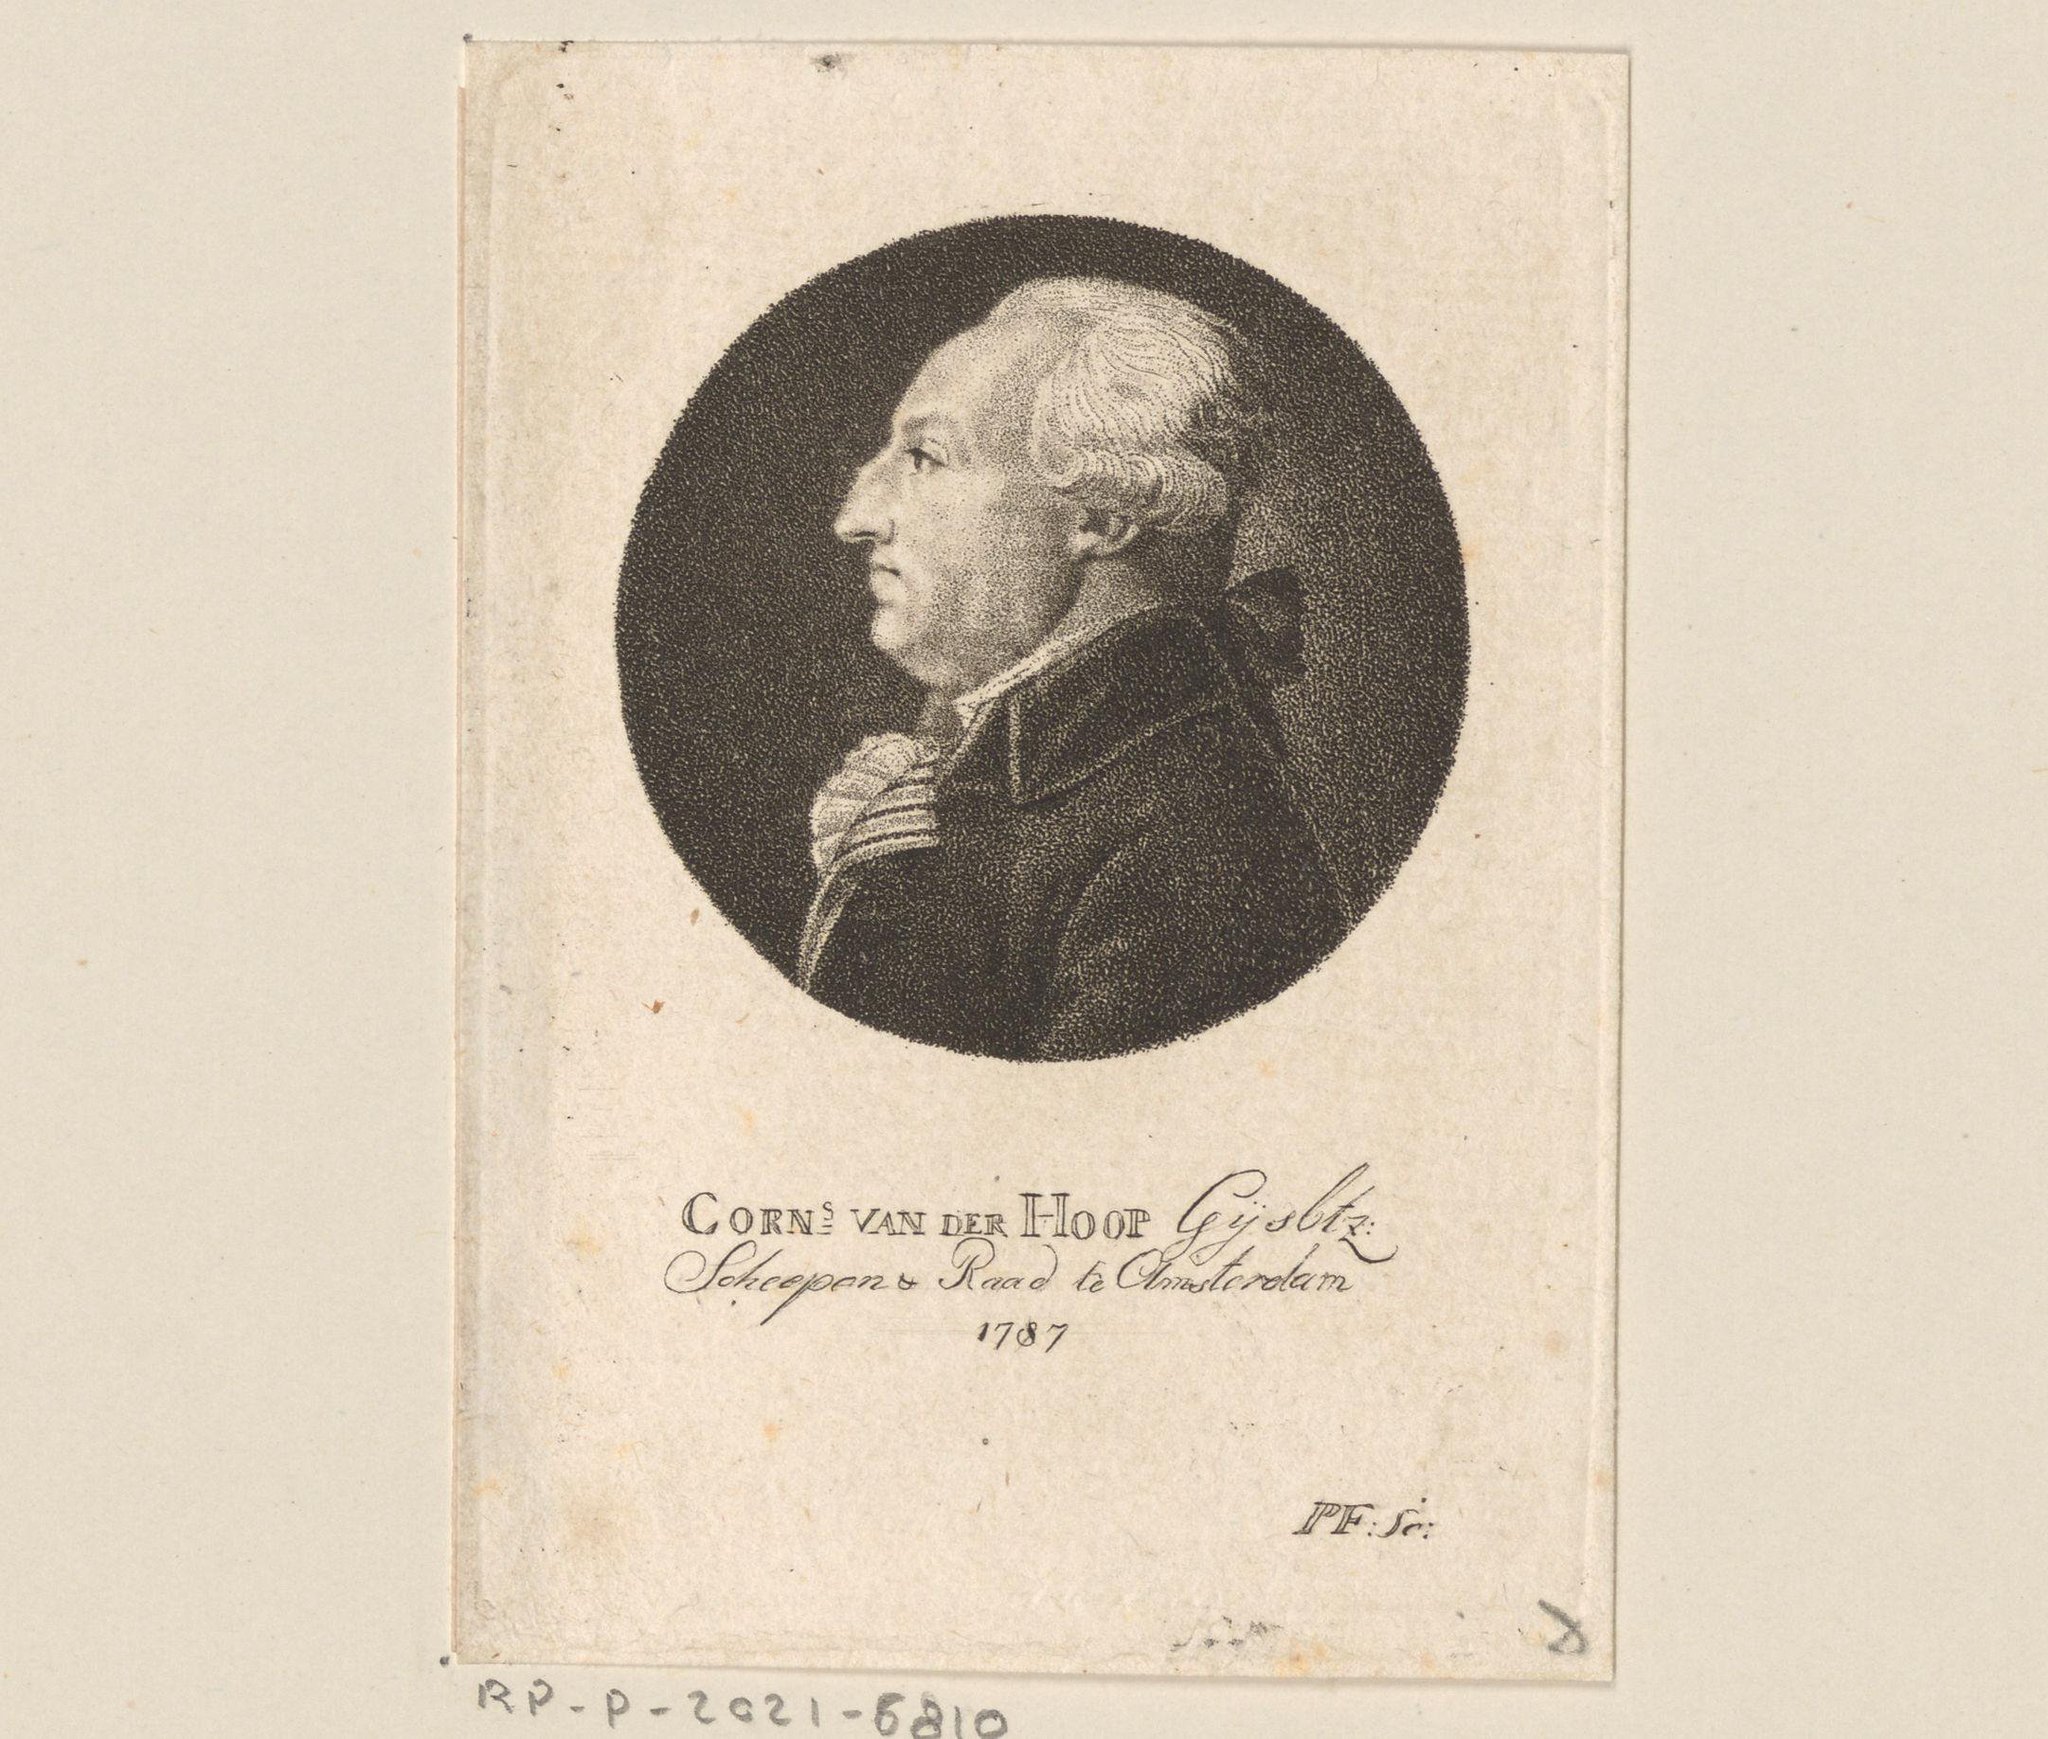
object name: print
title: Portret van Cornelis Gijsbertsz. van der Hoop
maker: monogrammist pf (prentmaker)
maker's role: print maker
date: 1787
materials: paper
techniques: etching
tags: amsterdam, historical persons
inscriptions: date